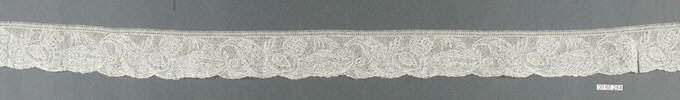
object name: strip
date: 1701-1800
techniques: lace